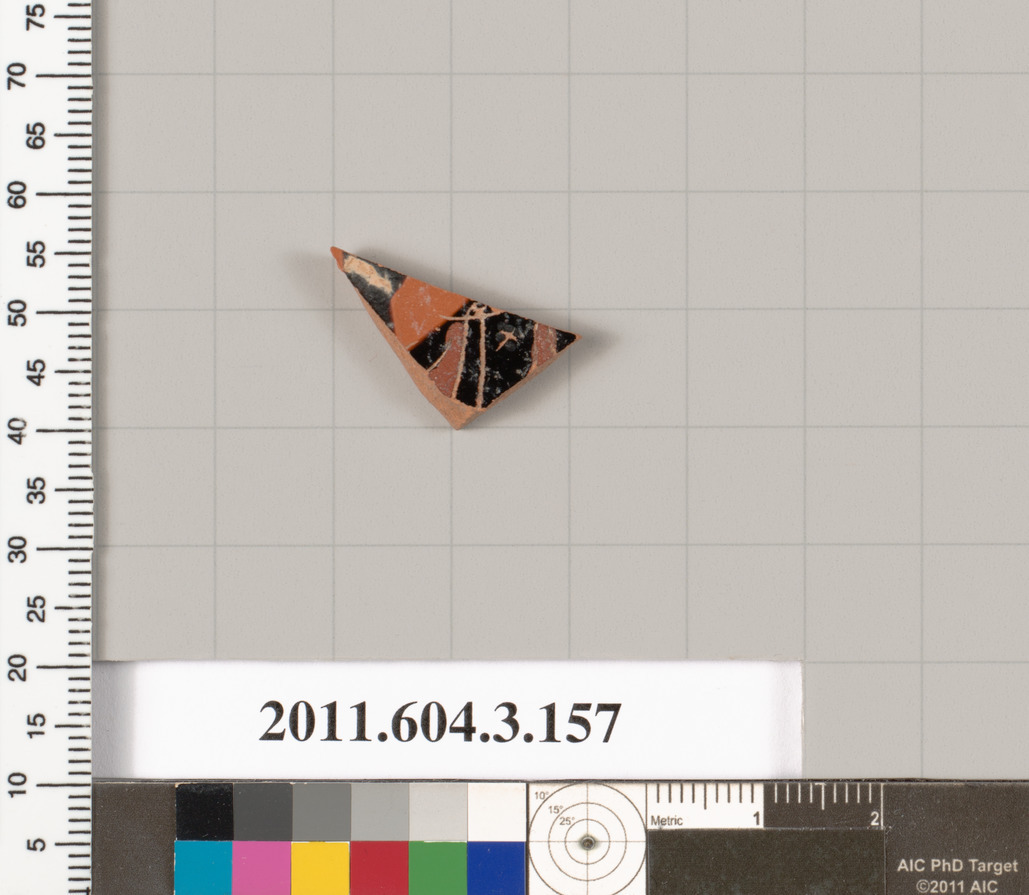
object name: amphora fragment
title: Terracotta fragment of an amphora (jar)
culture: greek, attic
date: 550-540 BCE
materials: terracotta